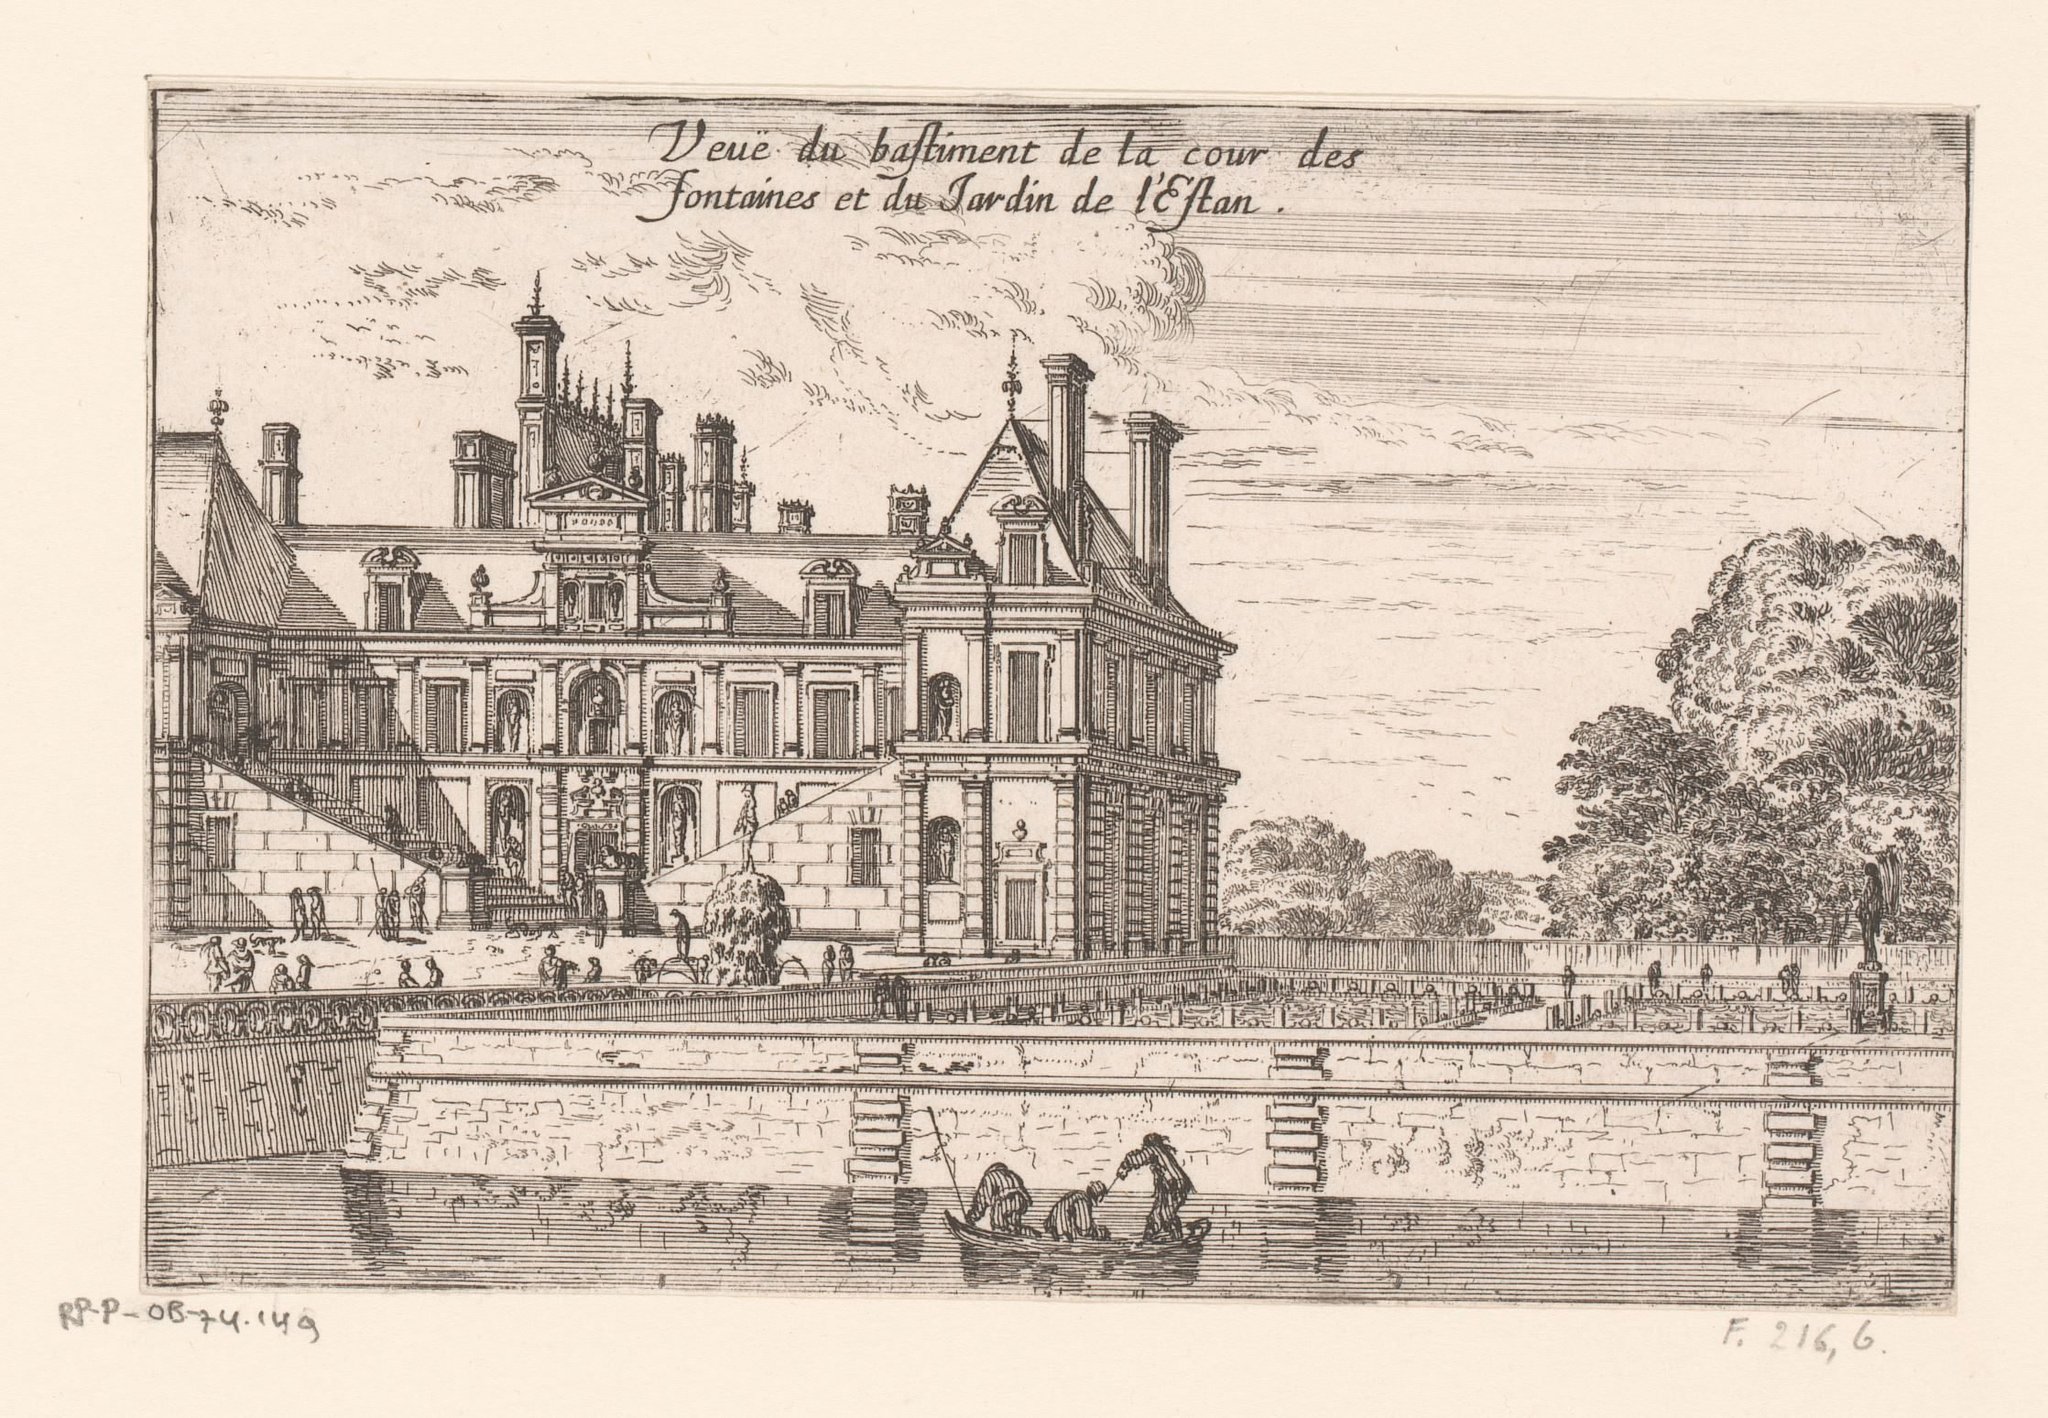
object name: print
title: Veue de bastiment de la cour des fontaines et du Jardin de l'Estan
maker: israël silvestre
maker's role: draughtsman, print maker, publisher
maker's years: 1621-1691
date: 1631-1691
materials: paper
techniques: engraving, etching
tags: french or architectonic garden; formal garden, landscape with tower or castle (+ city(-scape) with figures, staffage)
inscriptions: collector's mark: Lugt 240